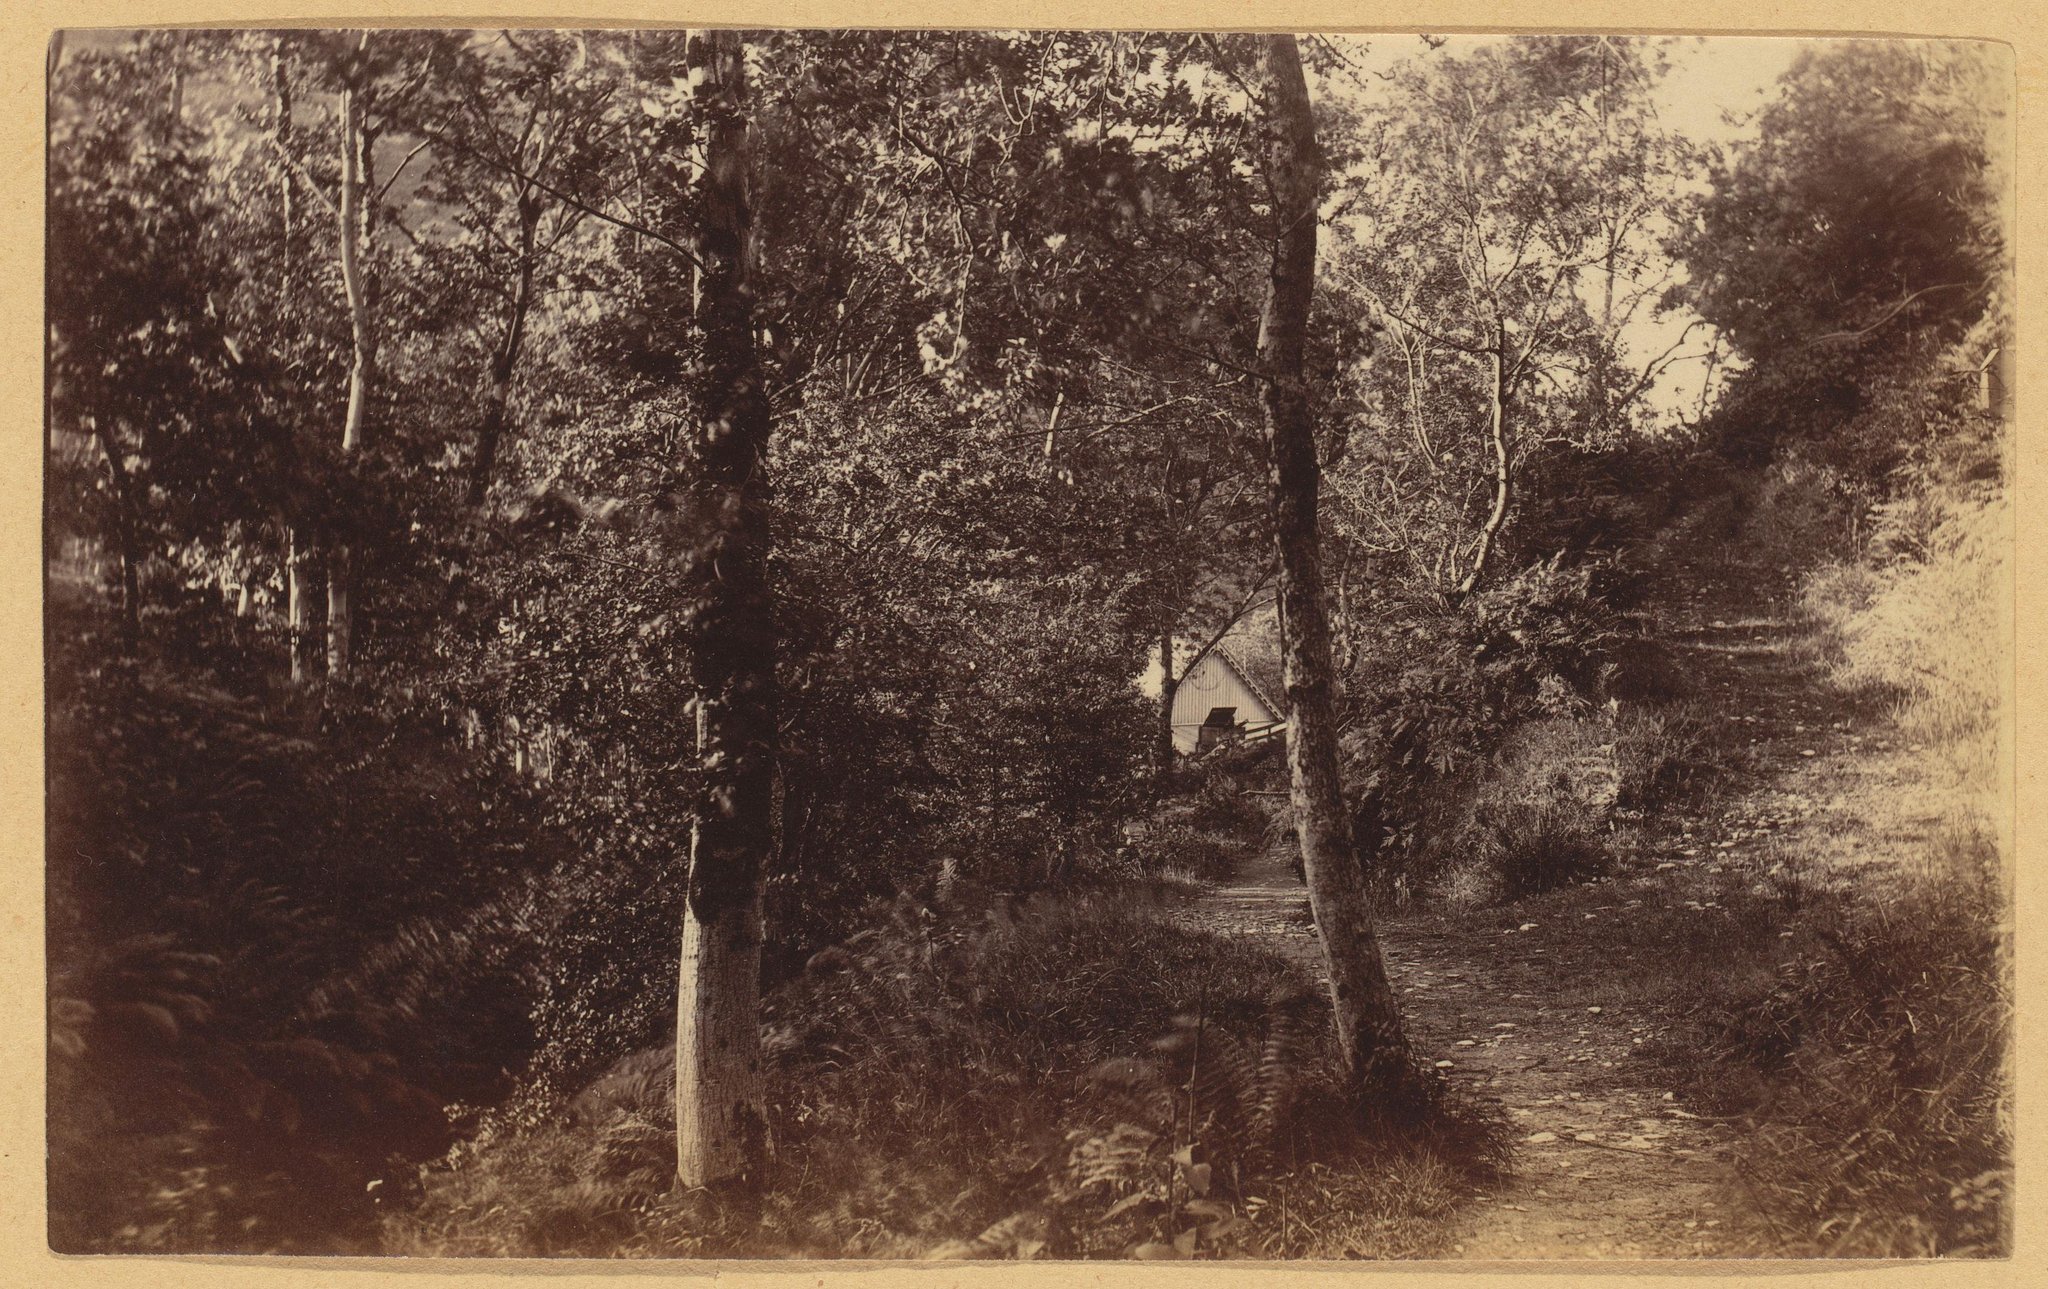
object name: album leaf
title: Bos met dak van huis, Sulby Glen, Isle of Man, Verenigd Koninkrijk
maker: Anonymous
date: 1870-1890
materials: cardboard, paper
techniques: albumen print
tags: great britain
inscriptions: caption: ‘Dhoon Glen.’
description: Foto zit samen met RP-F-00-6312-1(V) en RP-F-00-6312-2(V) op één albumblad geplakt.